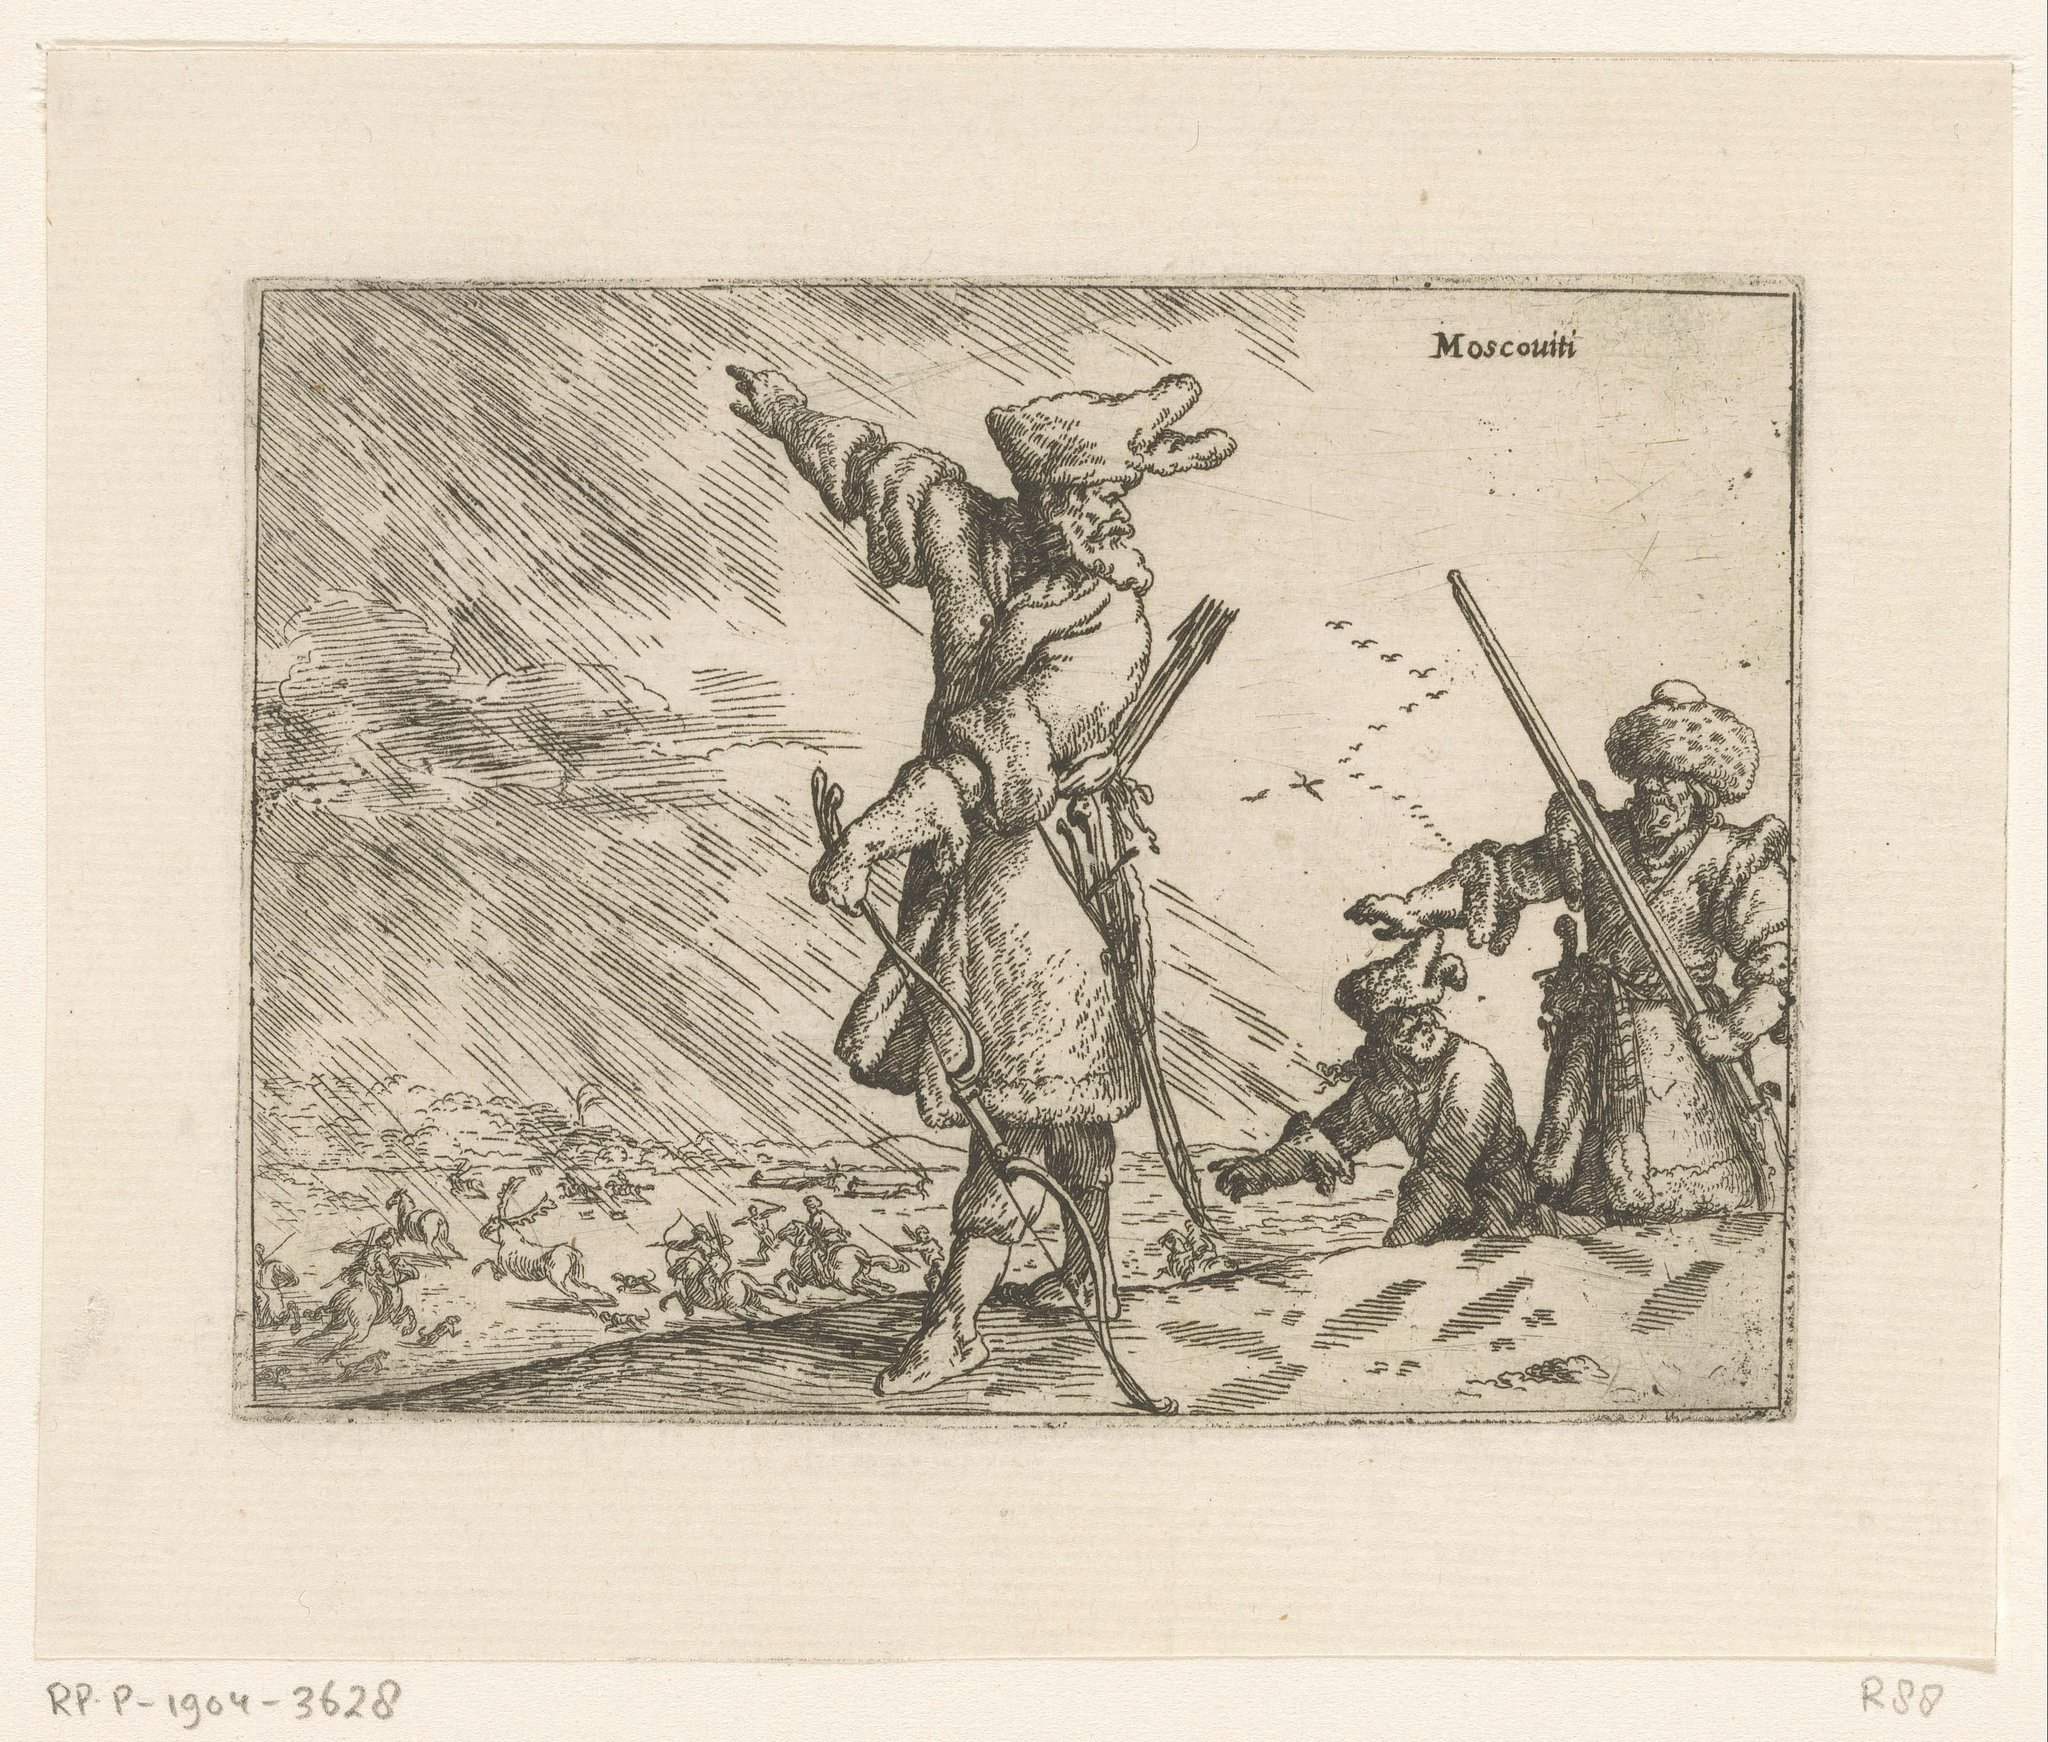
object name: print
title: Drie Russen, een jachtscène in de achtergrond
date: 1636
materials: paper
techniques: etching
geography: rome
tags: archer's weapons: bow and arrow, stag-hunting, europeans (russians) (+ costume), clothes, costume (+ men's clothes), firearms: rifle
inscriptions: collector's mark: ‘N. Guerain (?)’, collector's mark: Lugt 2228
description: Elfde prent uit de serie 'Klederdrachten van verschillende volkeren', bestaand uit vijftien prenten en een titelprent.